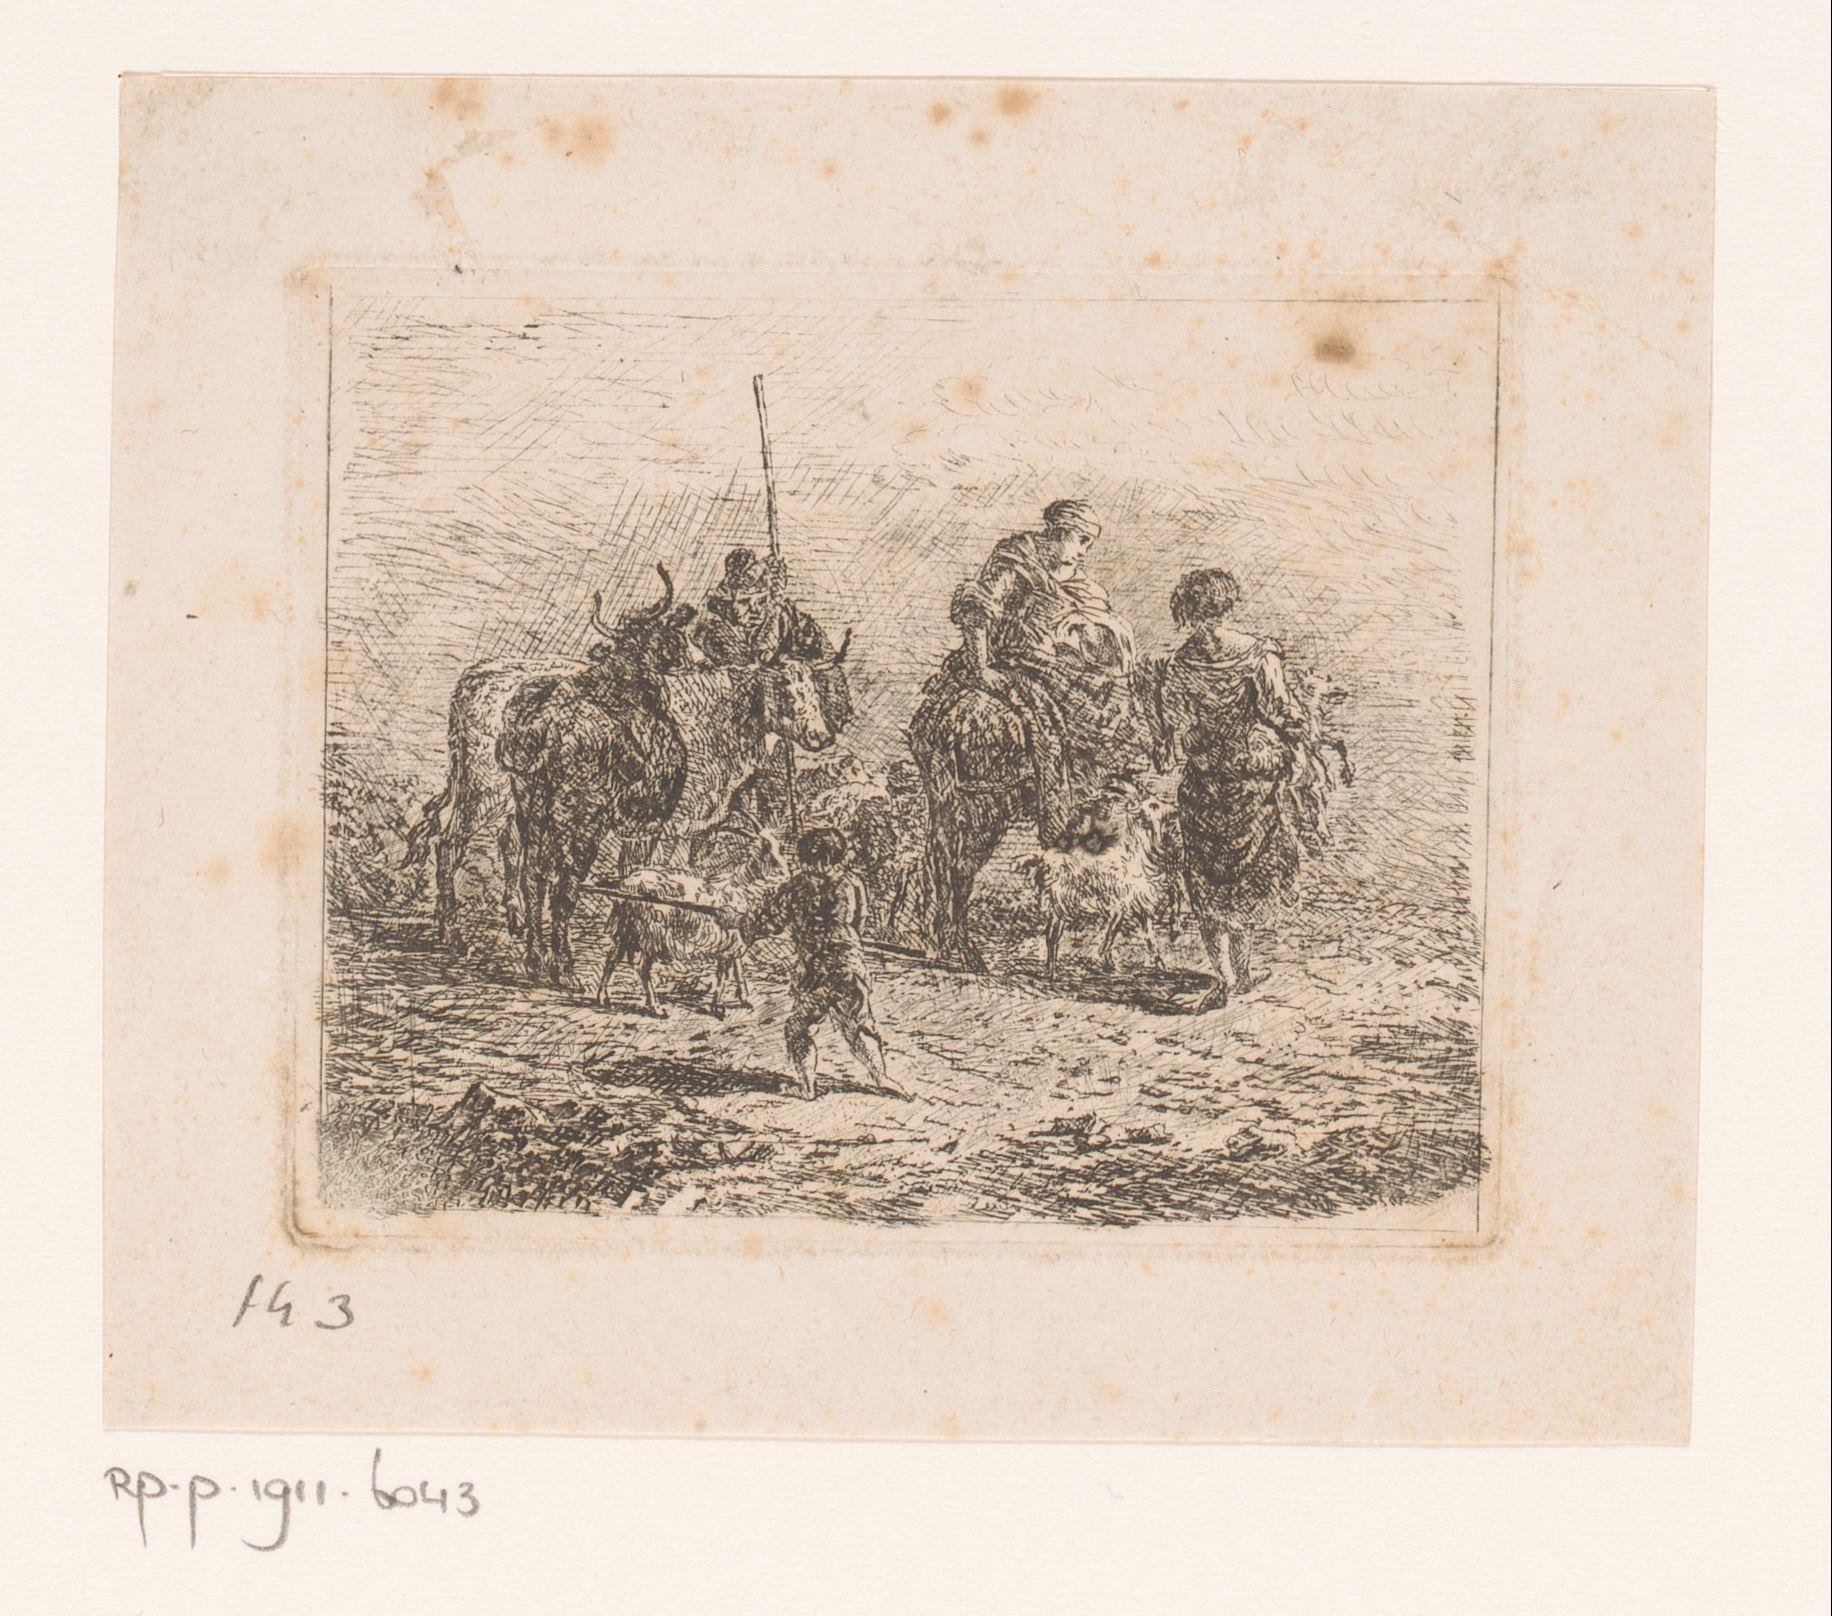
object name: print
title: Herdersgezin met kudde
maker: pierre-françois le roy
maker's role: draughtsman, painter, print maker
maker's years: 1771-1862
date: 1794-1862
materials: paper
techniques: etching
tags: herding, herdsman, herdswoman, shepherd, shepherdess, cowherd, etc.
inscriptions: collector's mark: Lugt 2228, collector's mark: Lugt 1485